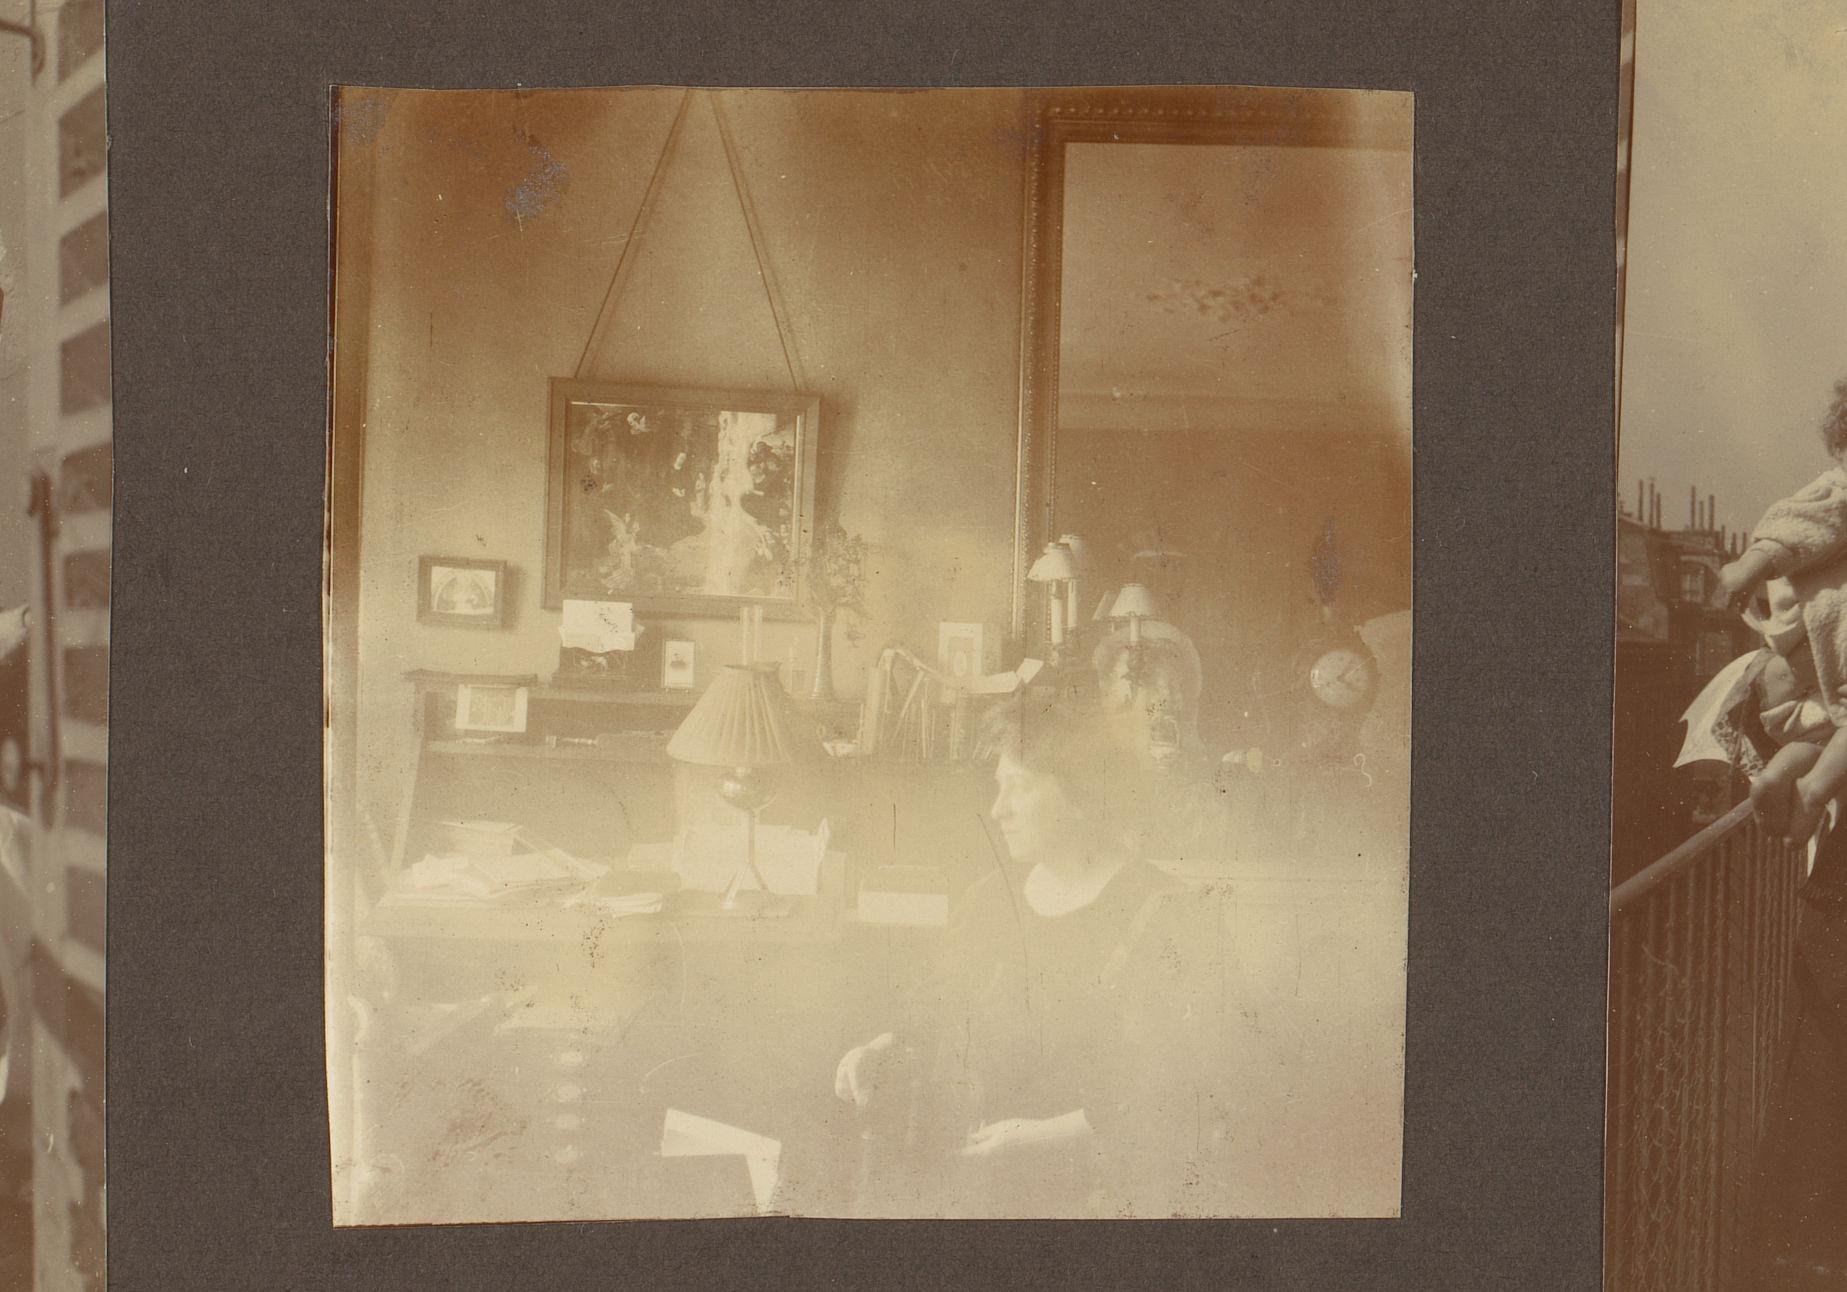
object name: photograph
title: Elsa Diepenbrock zit in een huiskamer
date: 1895-1925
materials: paper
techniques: daylight paper print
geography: paris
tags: jonkvrouw wilhelmina elisabeth petronella cornelia de jong van beek en donk, historical persons - bb - woman, living-room, parlour, sitting-room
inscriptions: inscription: ‘Rue de L'Université 12’